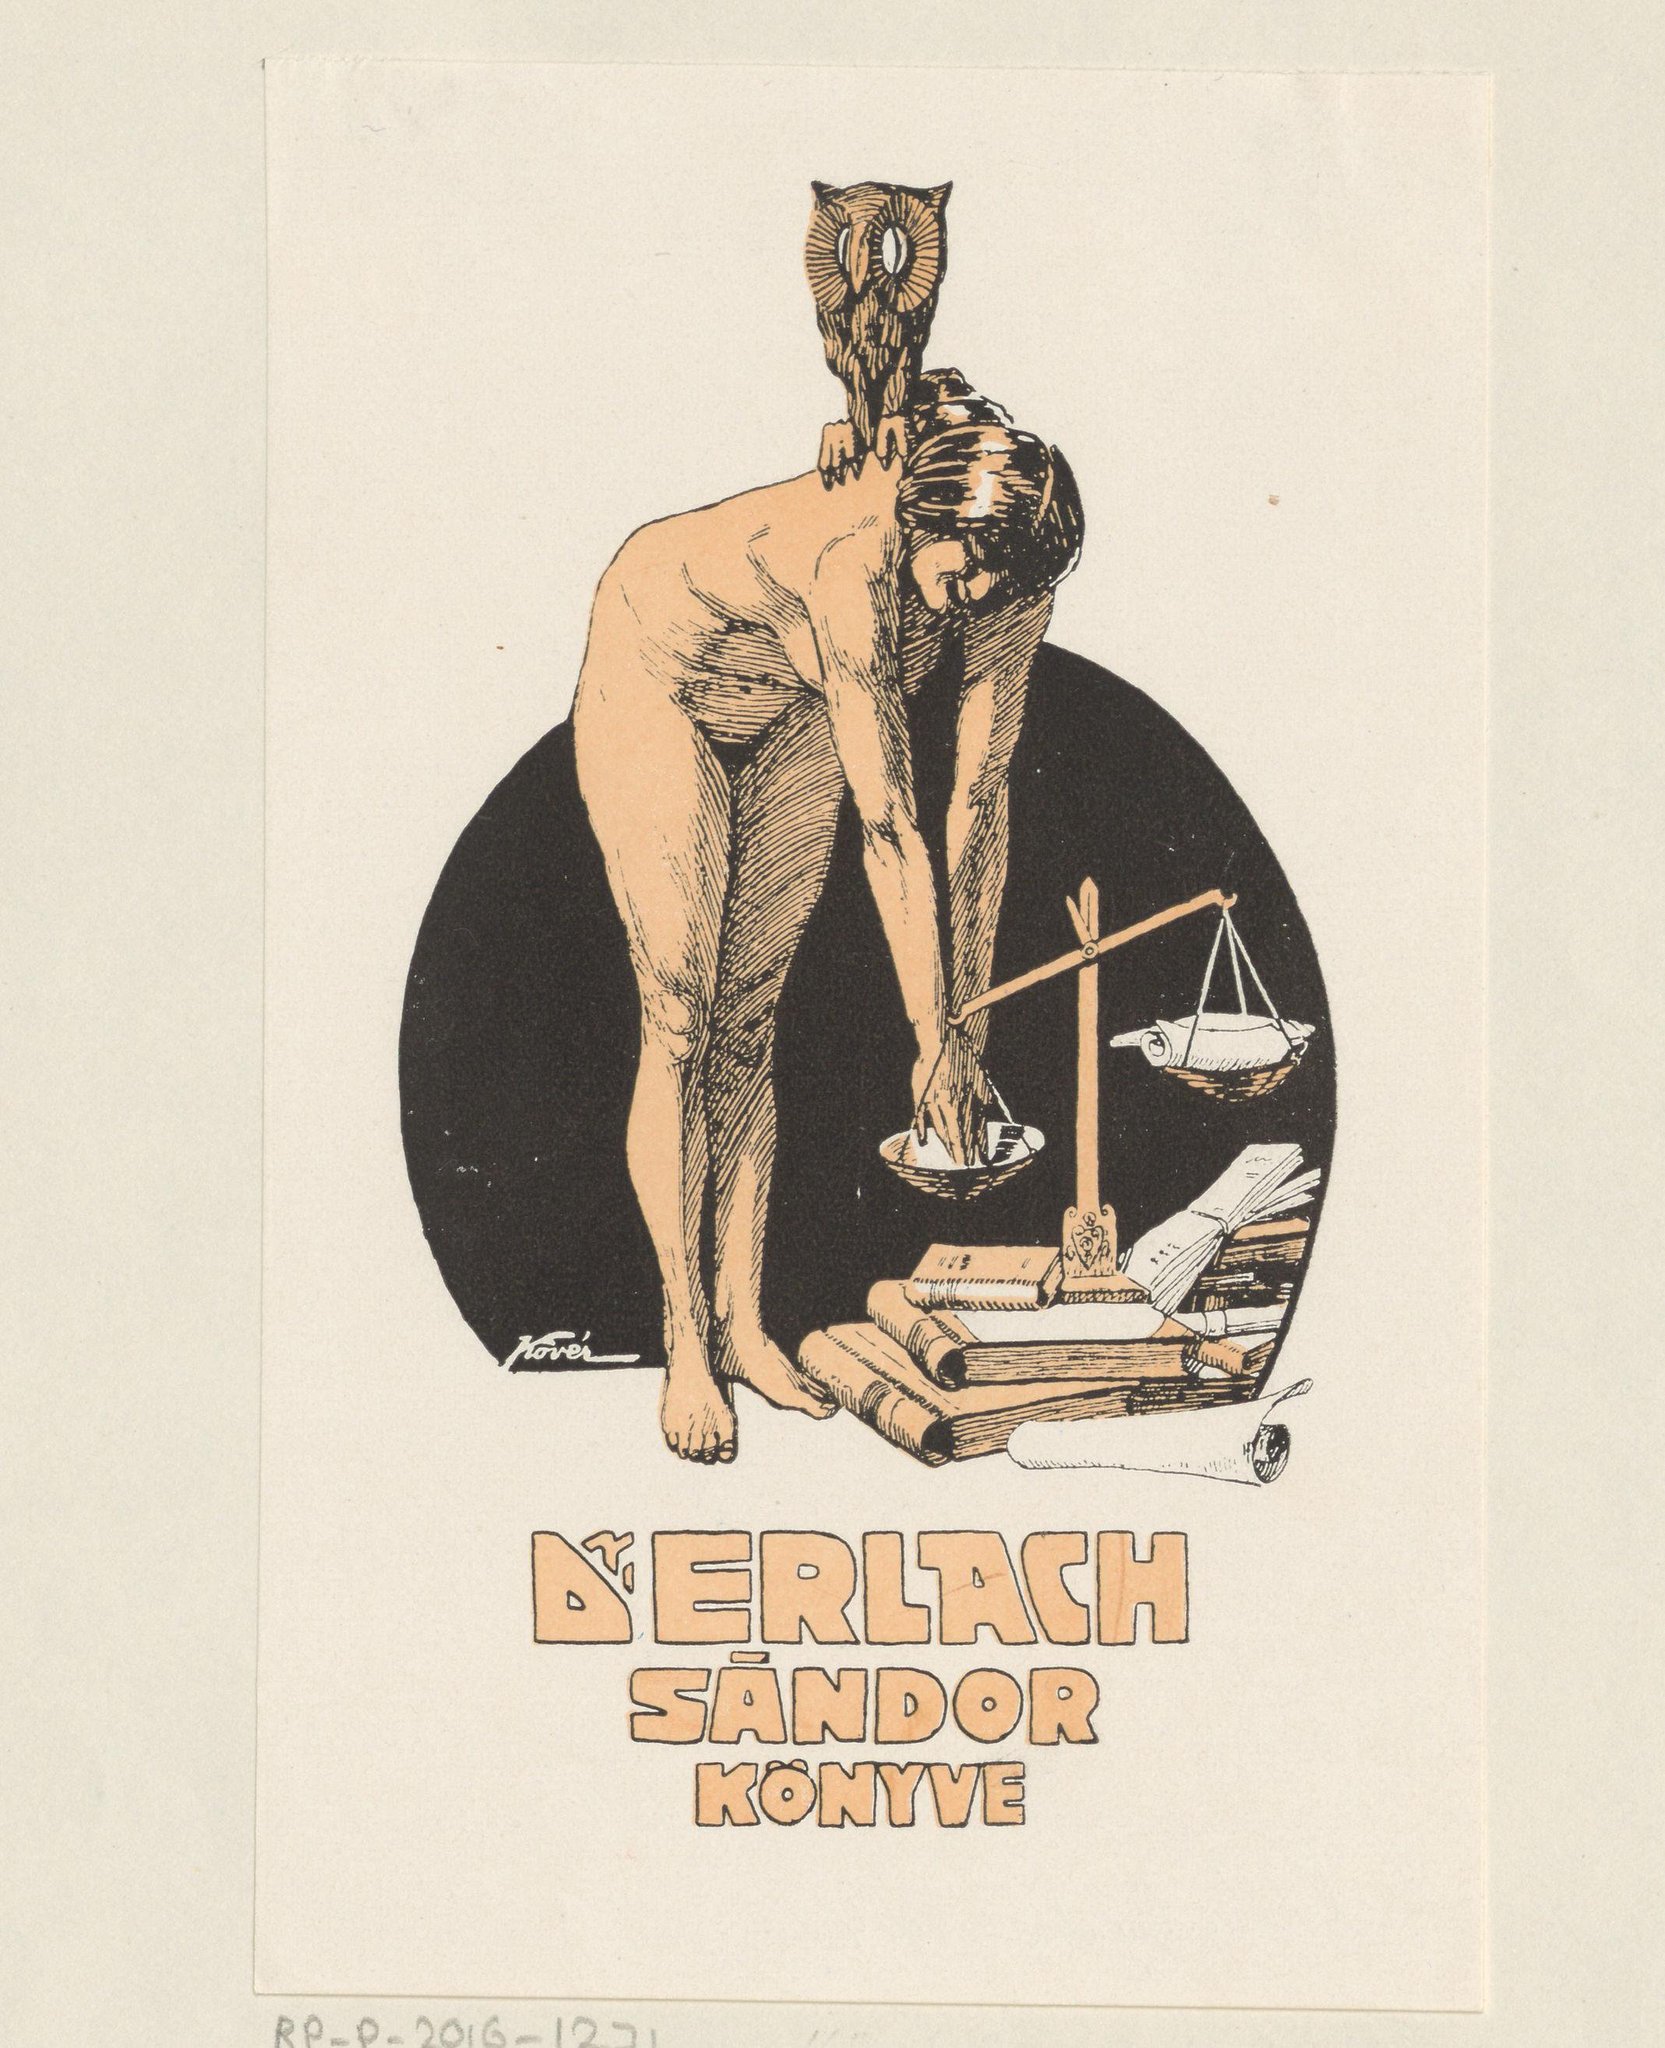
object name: bookplate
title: Ex libris van dr. Erlach Sándor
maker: gyula kövér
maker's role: print maker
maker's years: 1883-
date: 1914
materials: paper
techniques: printing block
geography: hungary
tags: scales, the (nude) human figure; 'corpo humano' (ripa) - aa - female human figure